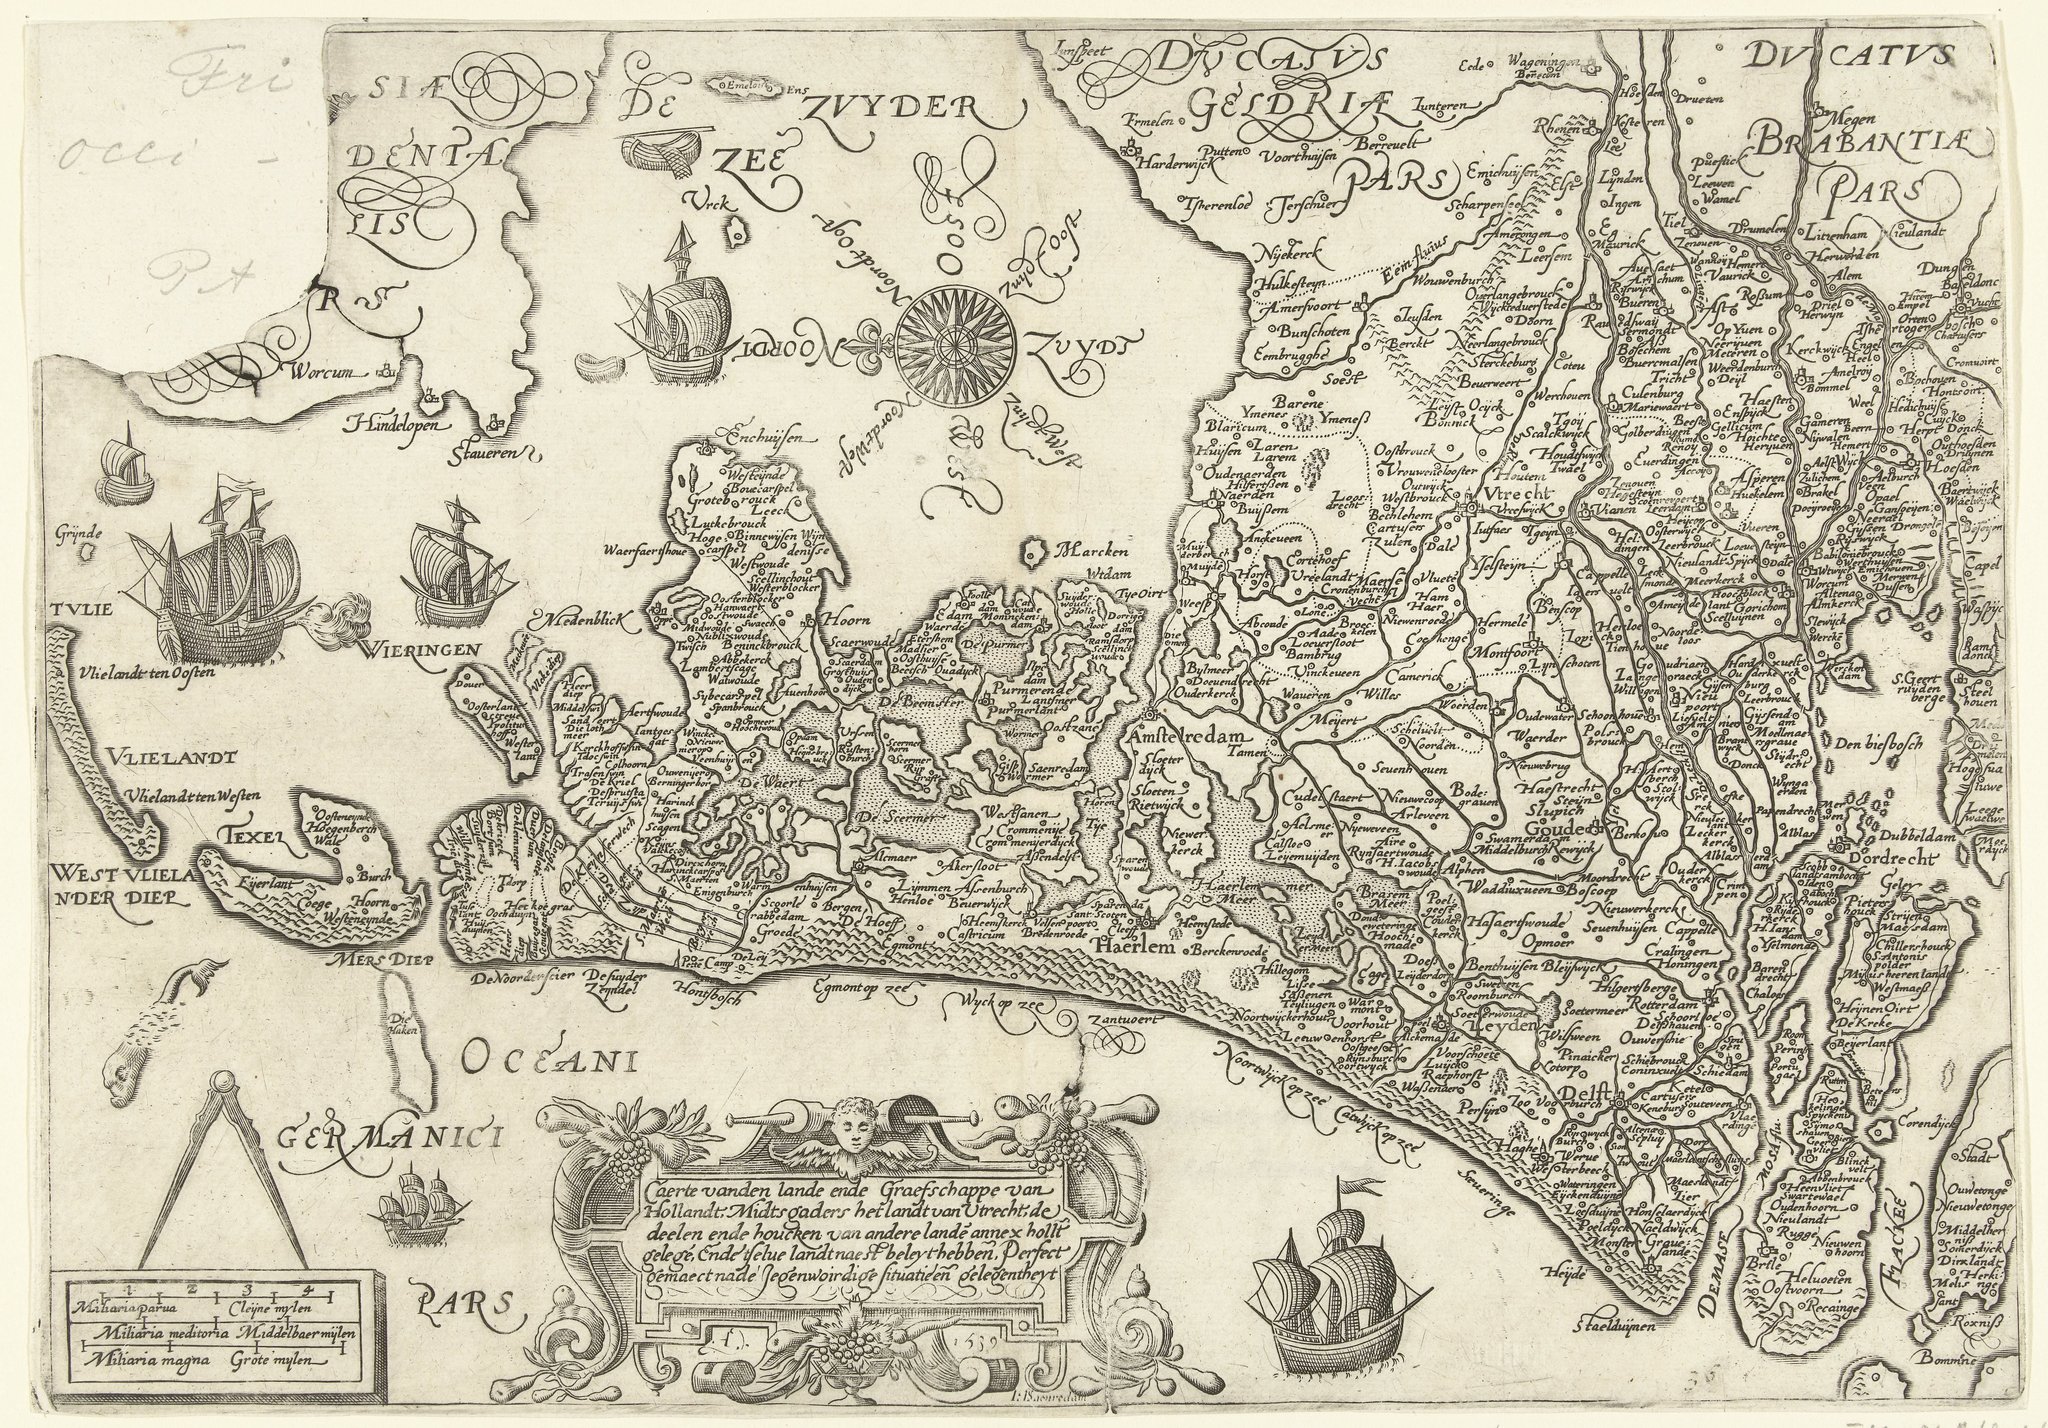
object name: map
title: Caerte vanden lande ende graefschappe van Hollandt; midtsgaders het landt van Utrecht; de deelen …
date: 1589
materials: paper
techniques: engraving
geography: antwerp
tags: coat of arms (as symbol of the state, etc.), maps of separate countries or regions, holland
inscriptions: collector's mark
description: Prent ook gebruikt in: Guicciardini, Lodovico. Omnivm Belgii, sive inferioris Germaniae regionvm descriptio […]. Amsterdam: Willem Janszoon Blaeu, 1613.